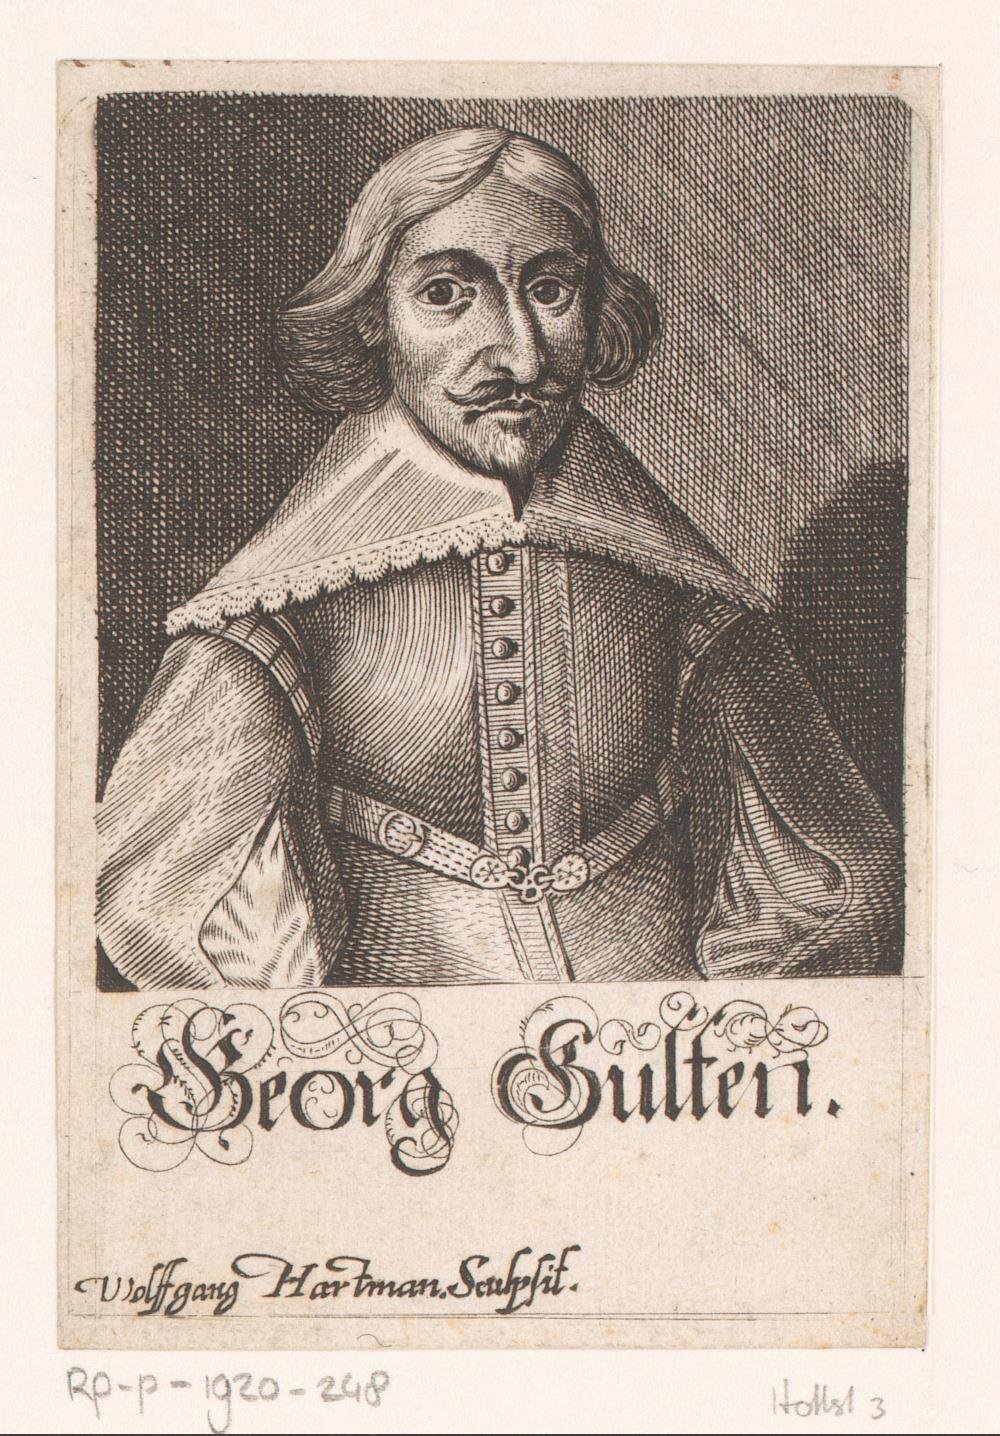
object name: print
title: Portret van Georg Gulten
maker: wolfgang hartmann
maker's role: print maker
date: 1640-1663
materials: paper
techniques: engraving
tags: historical persons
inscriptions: collector's mark: Lugt 2228